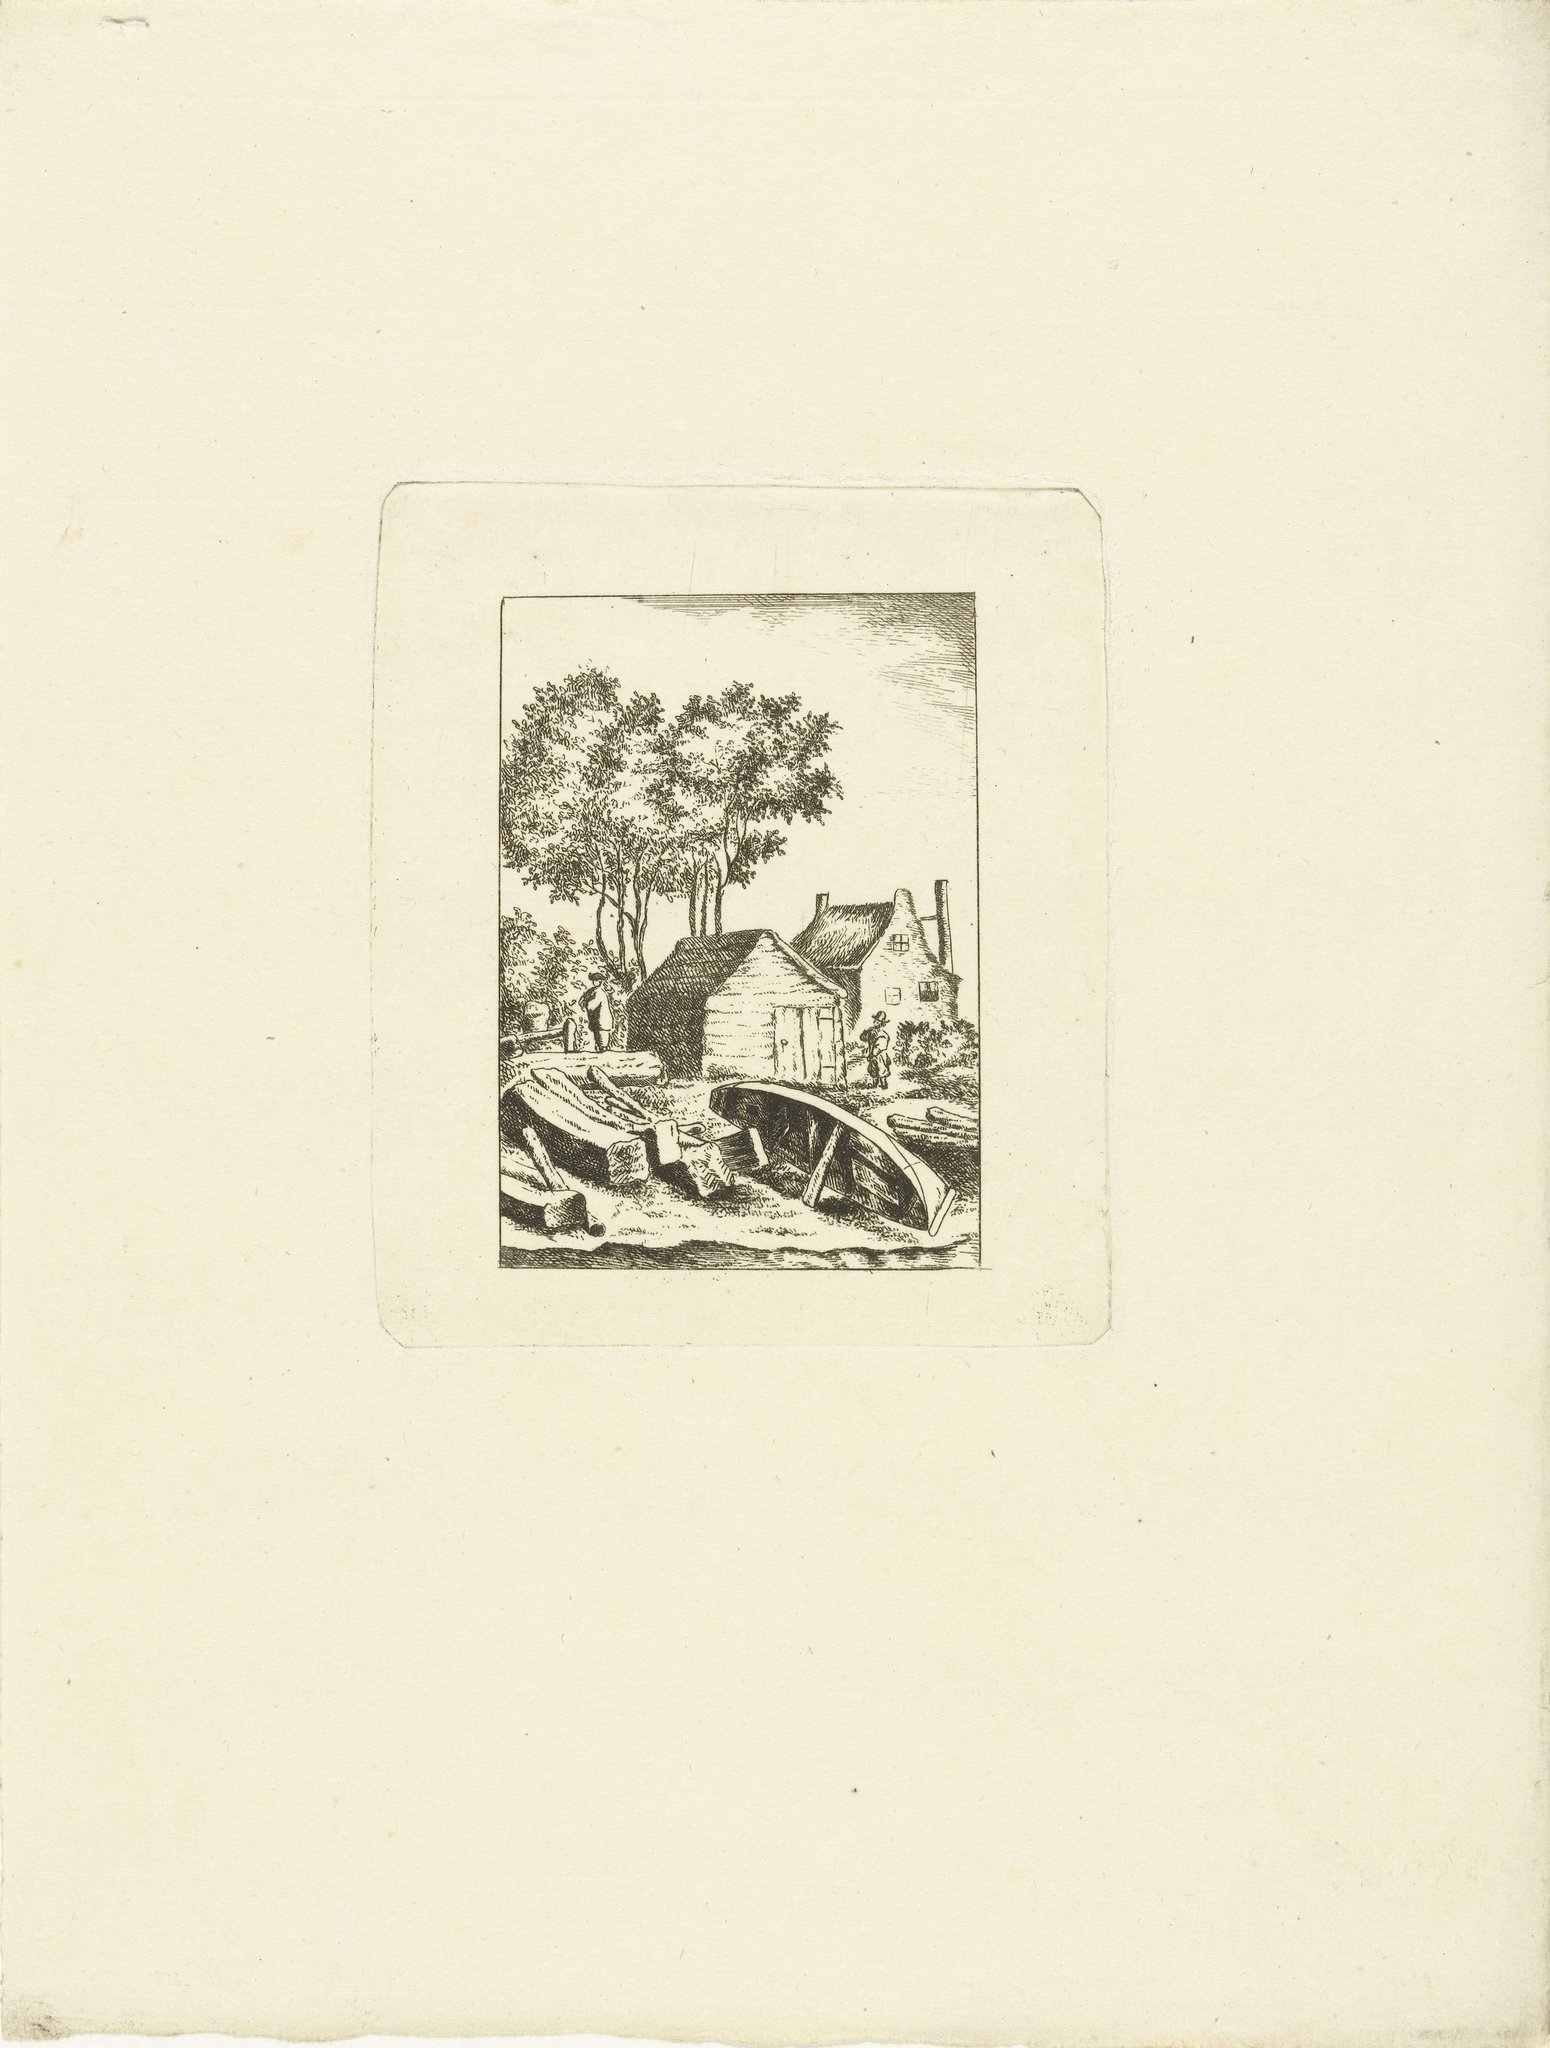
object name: print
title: Bootswerft met twee mannen aan het werk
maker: g. van citters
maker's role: print maker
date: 1750-1800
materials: paper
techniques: etching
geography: netherlands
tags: pier, quay, wharf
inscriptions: collector's mark: Lugt 2233